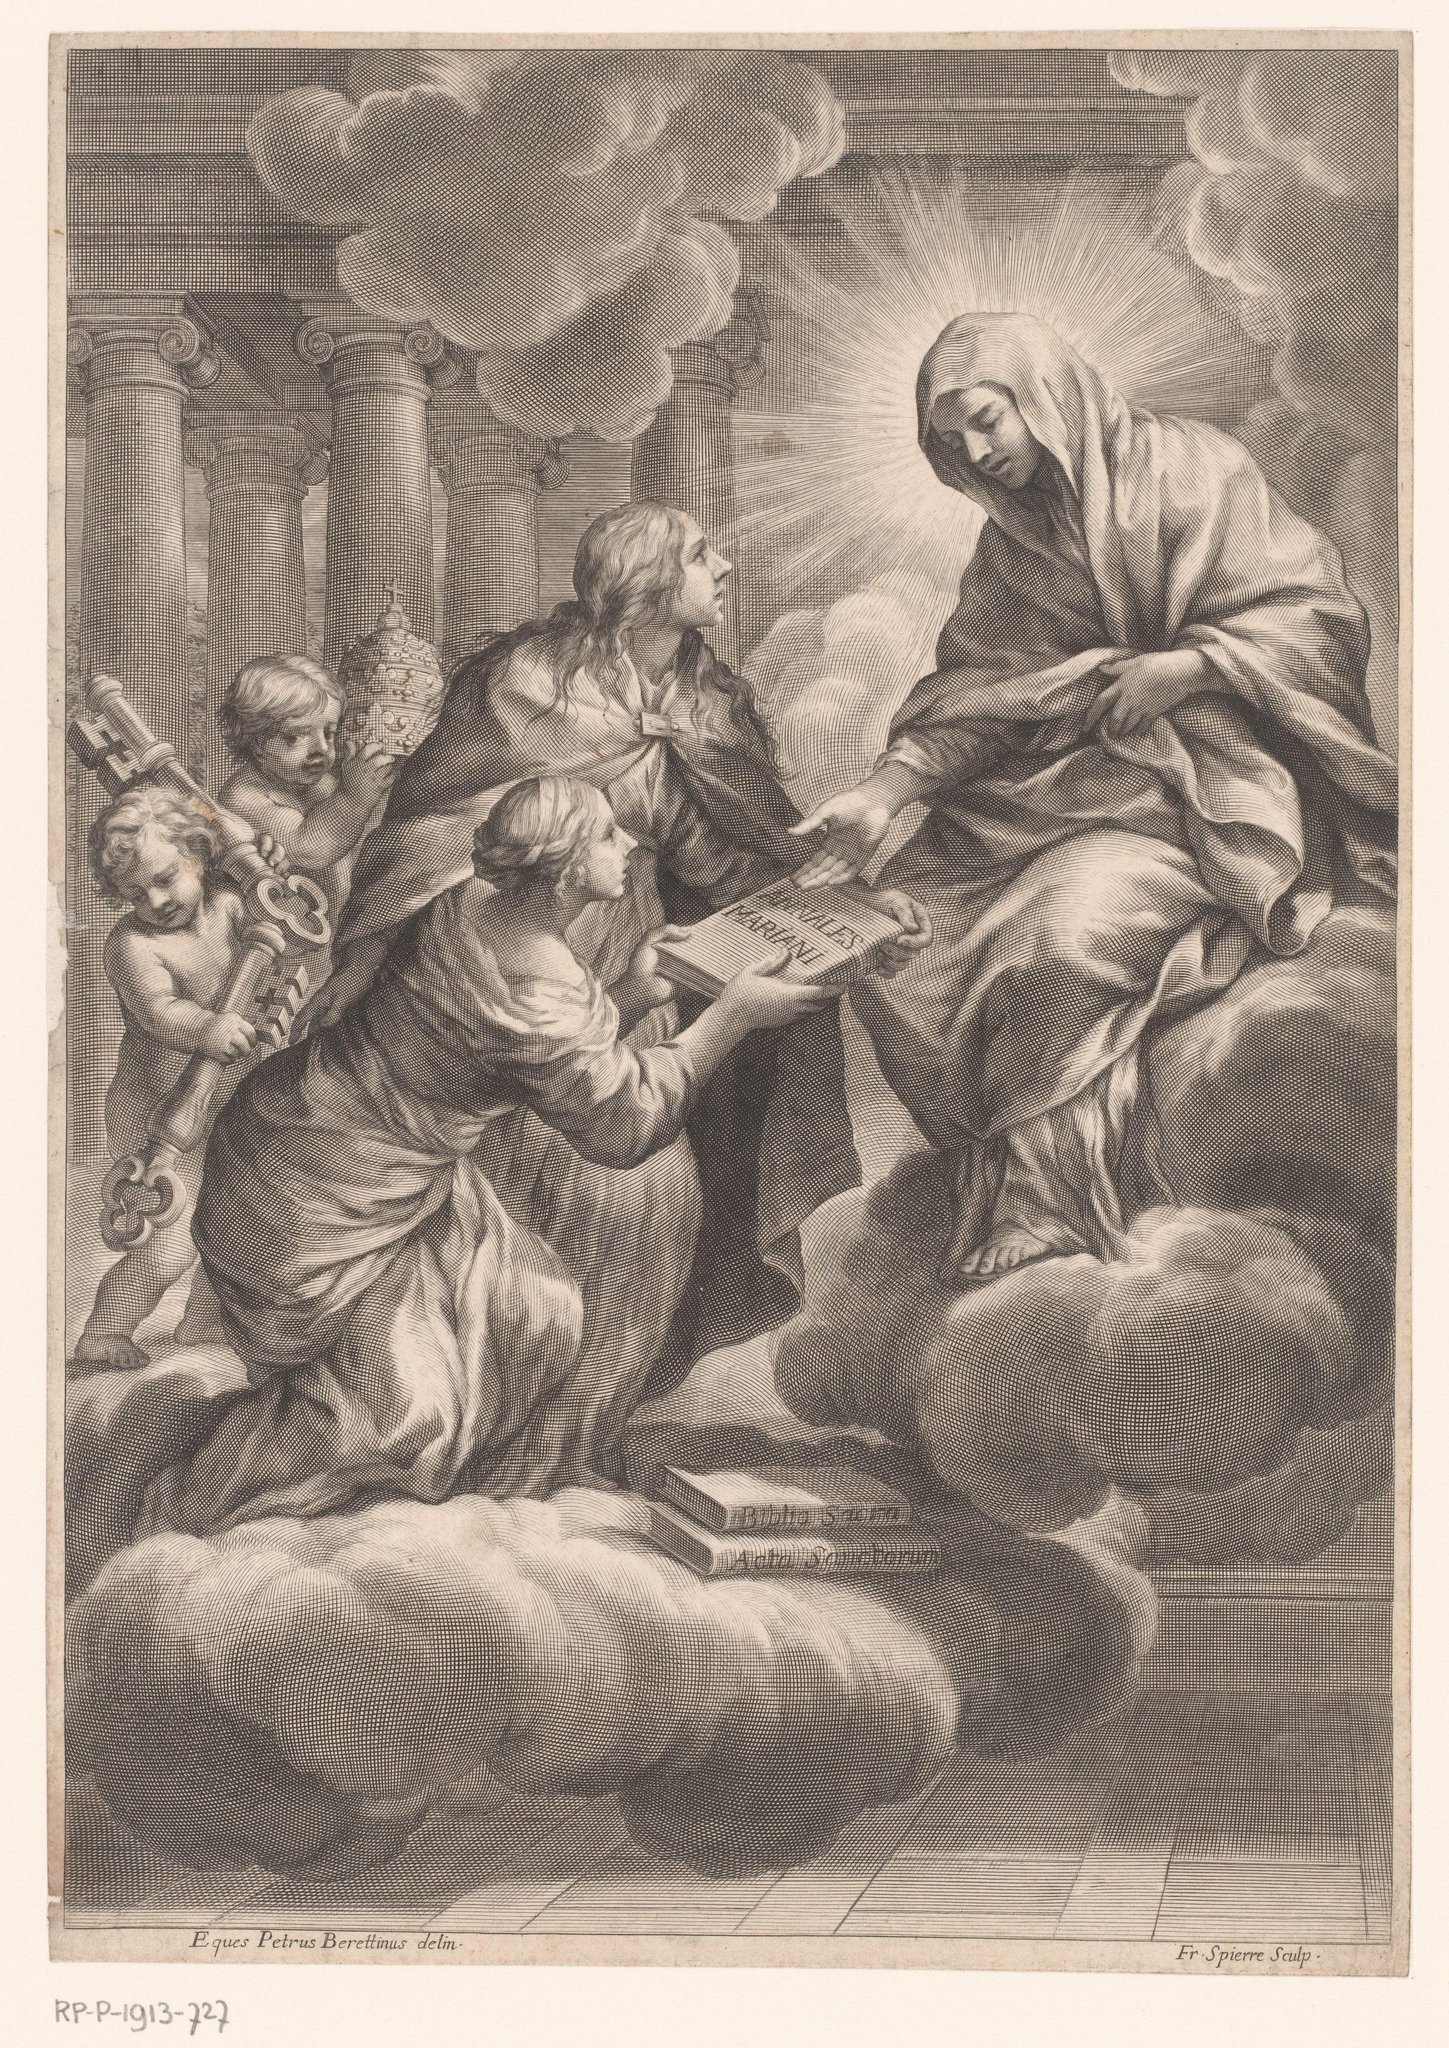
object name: print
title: Tronende Maria ontvangt drie boeken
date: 1661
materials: paper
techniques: engraving, etching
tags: key, mary enthroned, piety, 'pietas', 'timor dei' ~ the three theological virtues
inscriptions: collector's mark: Lugt 2233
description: Prent uit: Cancellotti, Giovanni Battista. Annales Mariani quibus historia SS. Virginis Mariae Dei genitricis in singulos annos distribuitur […]. Rome: Francisco Corbelletti, 1661, p. 2.